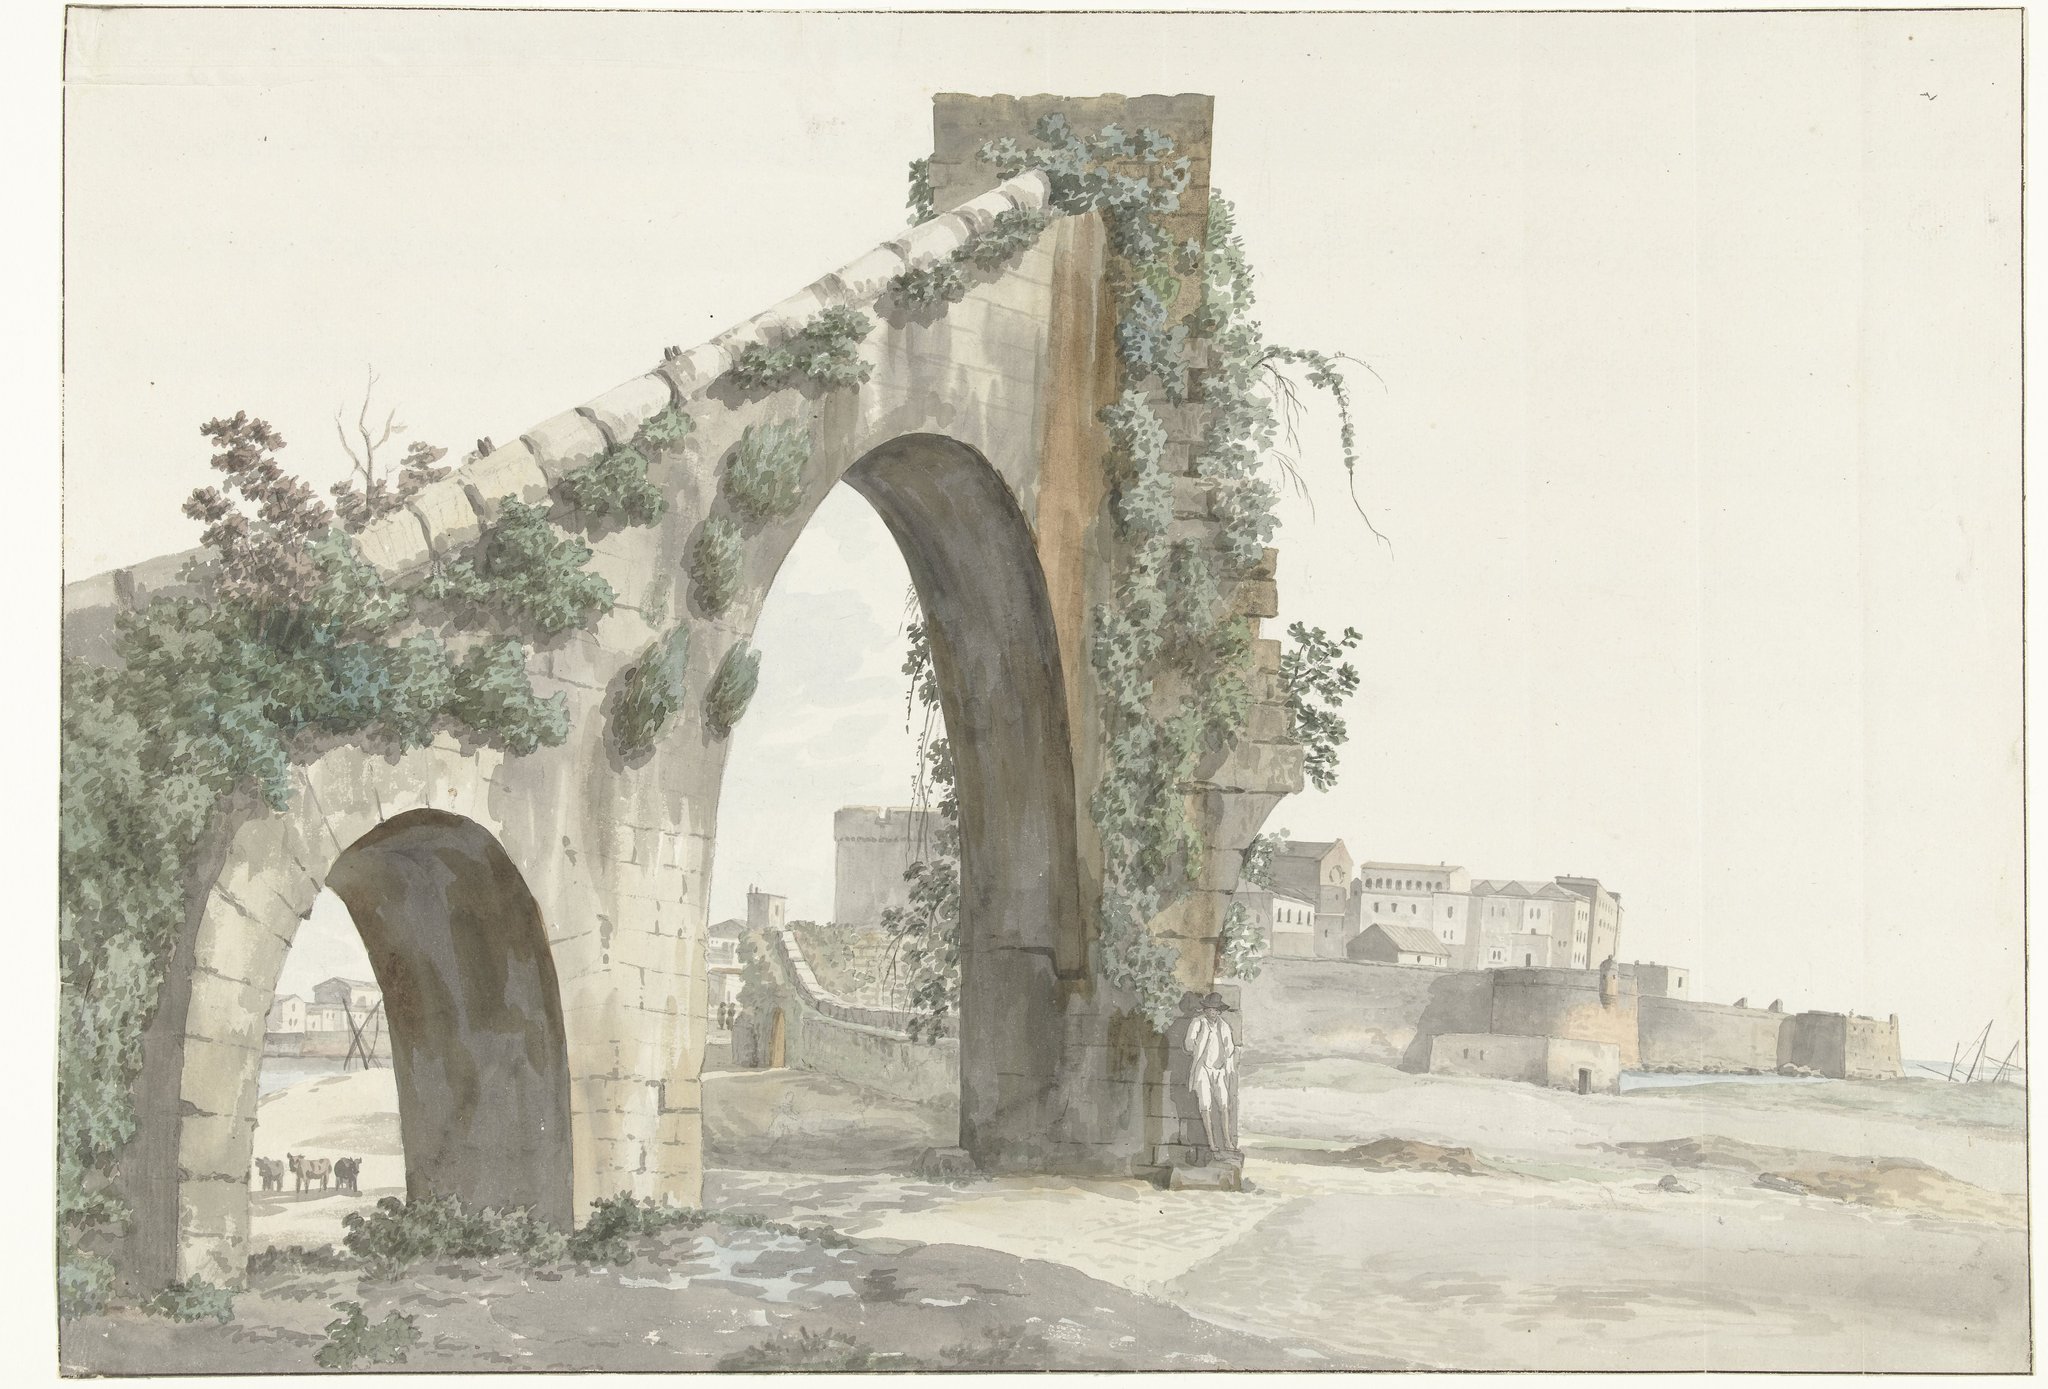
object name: drawing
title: Gezicht op aquaduct en de stad Tarente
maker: louis ducros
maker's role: draughtsman, print maker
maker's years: 1748-1810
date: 1778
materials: chalk, paper, watercolor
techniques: brush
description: Tekening uit het album 'Voyage en Italie, en Sicile et à Malte', 1778.